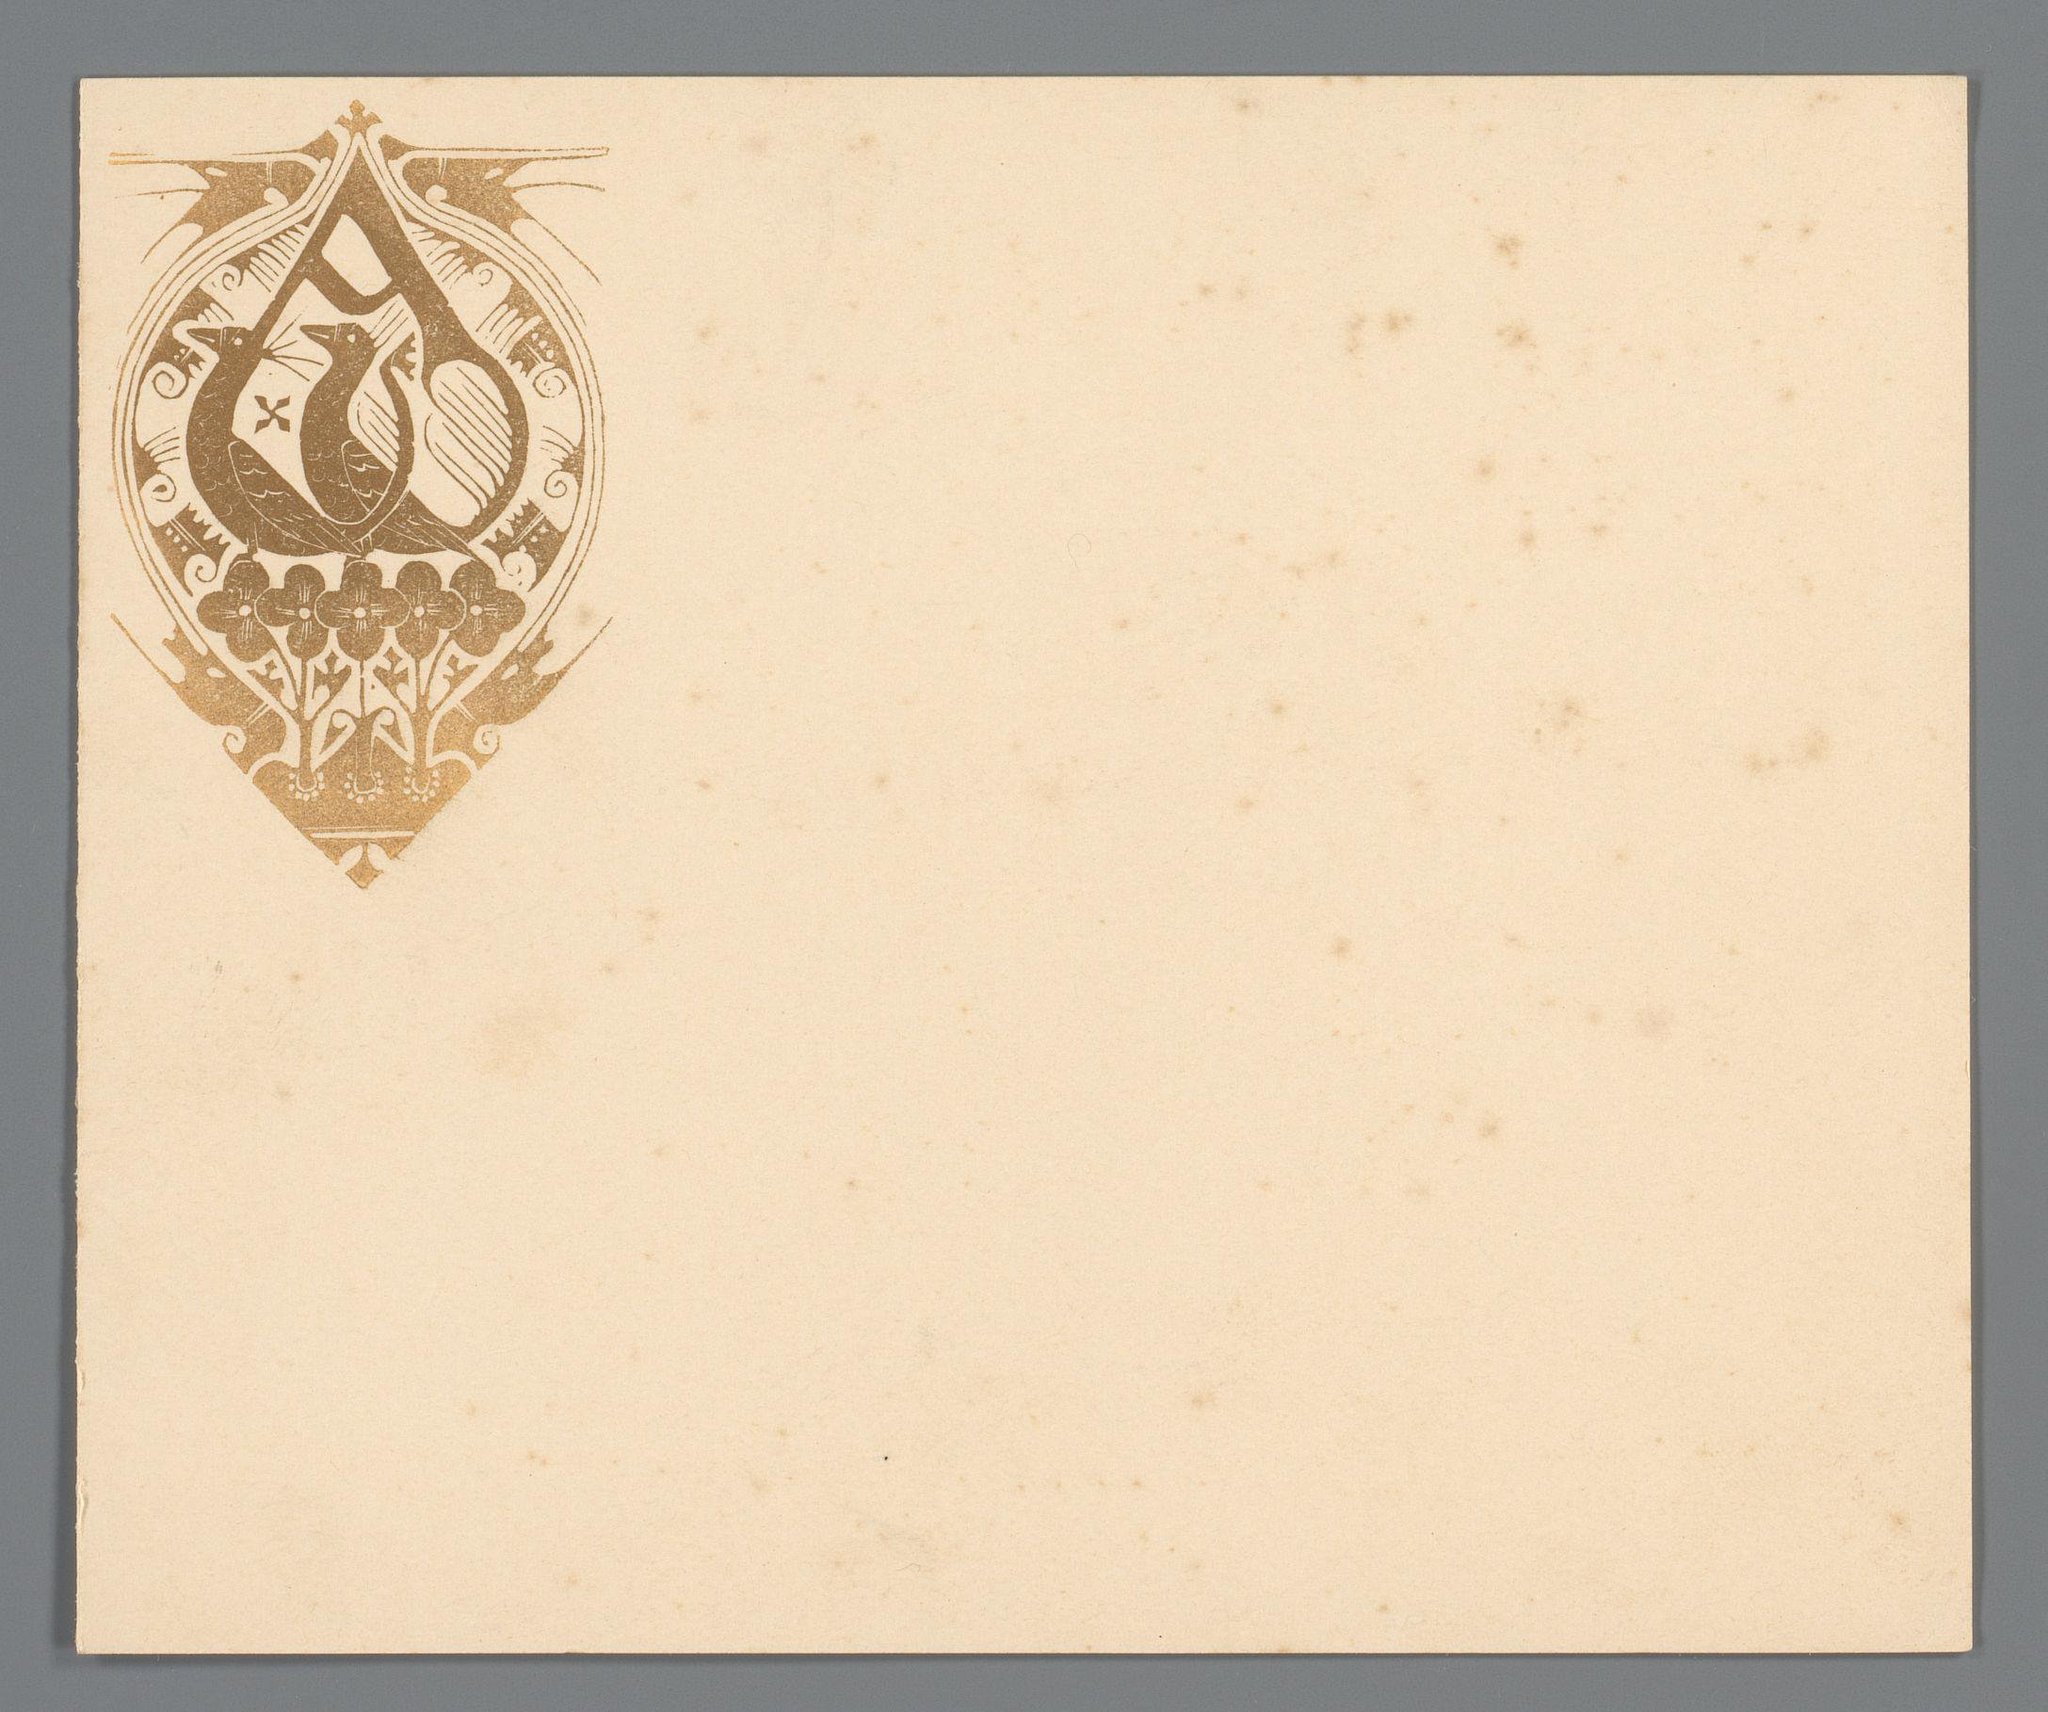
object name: stationery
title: Briefpapier met als briefhoofd een vignet met de Griekse letters Alpha en Omega gevormd door pauwen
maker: mathieu lauweriks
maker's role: designer, draughtsman, print maker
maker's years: 1864-1932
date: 1890-1900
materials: paper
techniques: woodcut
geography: amsterdam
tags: greek script, ornament derived from animal forms, miscellaneous religions, cults and doctrines: theosophy, ornamental birds: peacock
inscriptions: name: ‘Bazel & Lauweriks, Amsterdam’